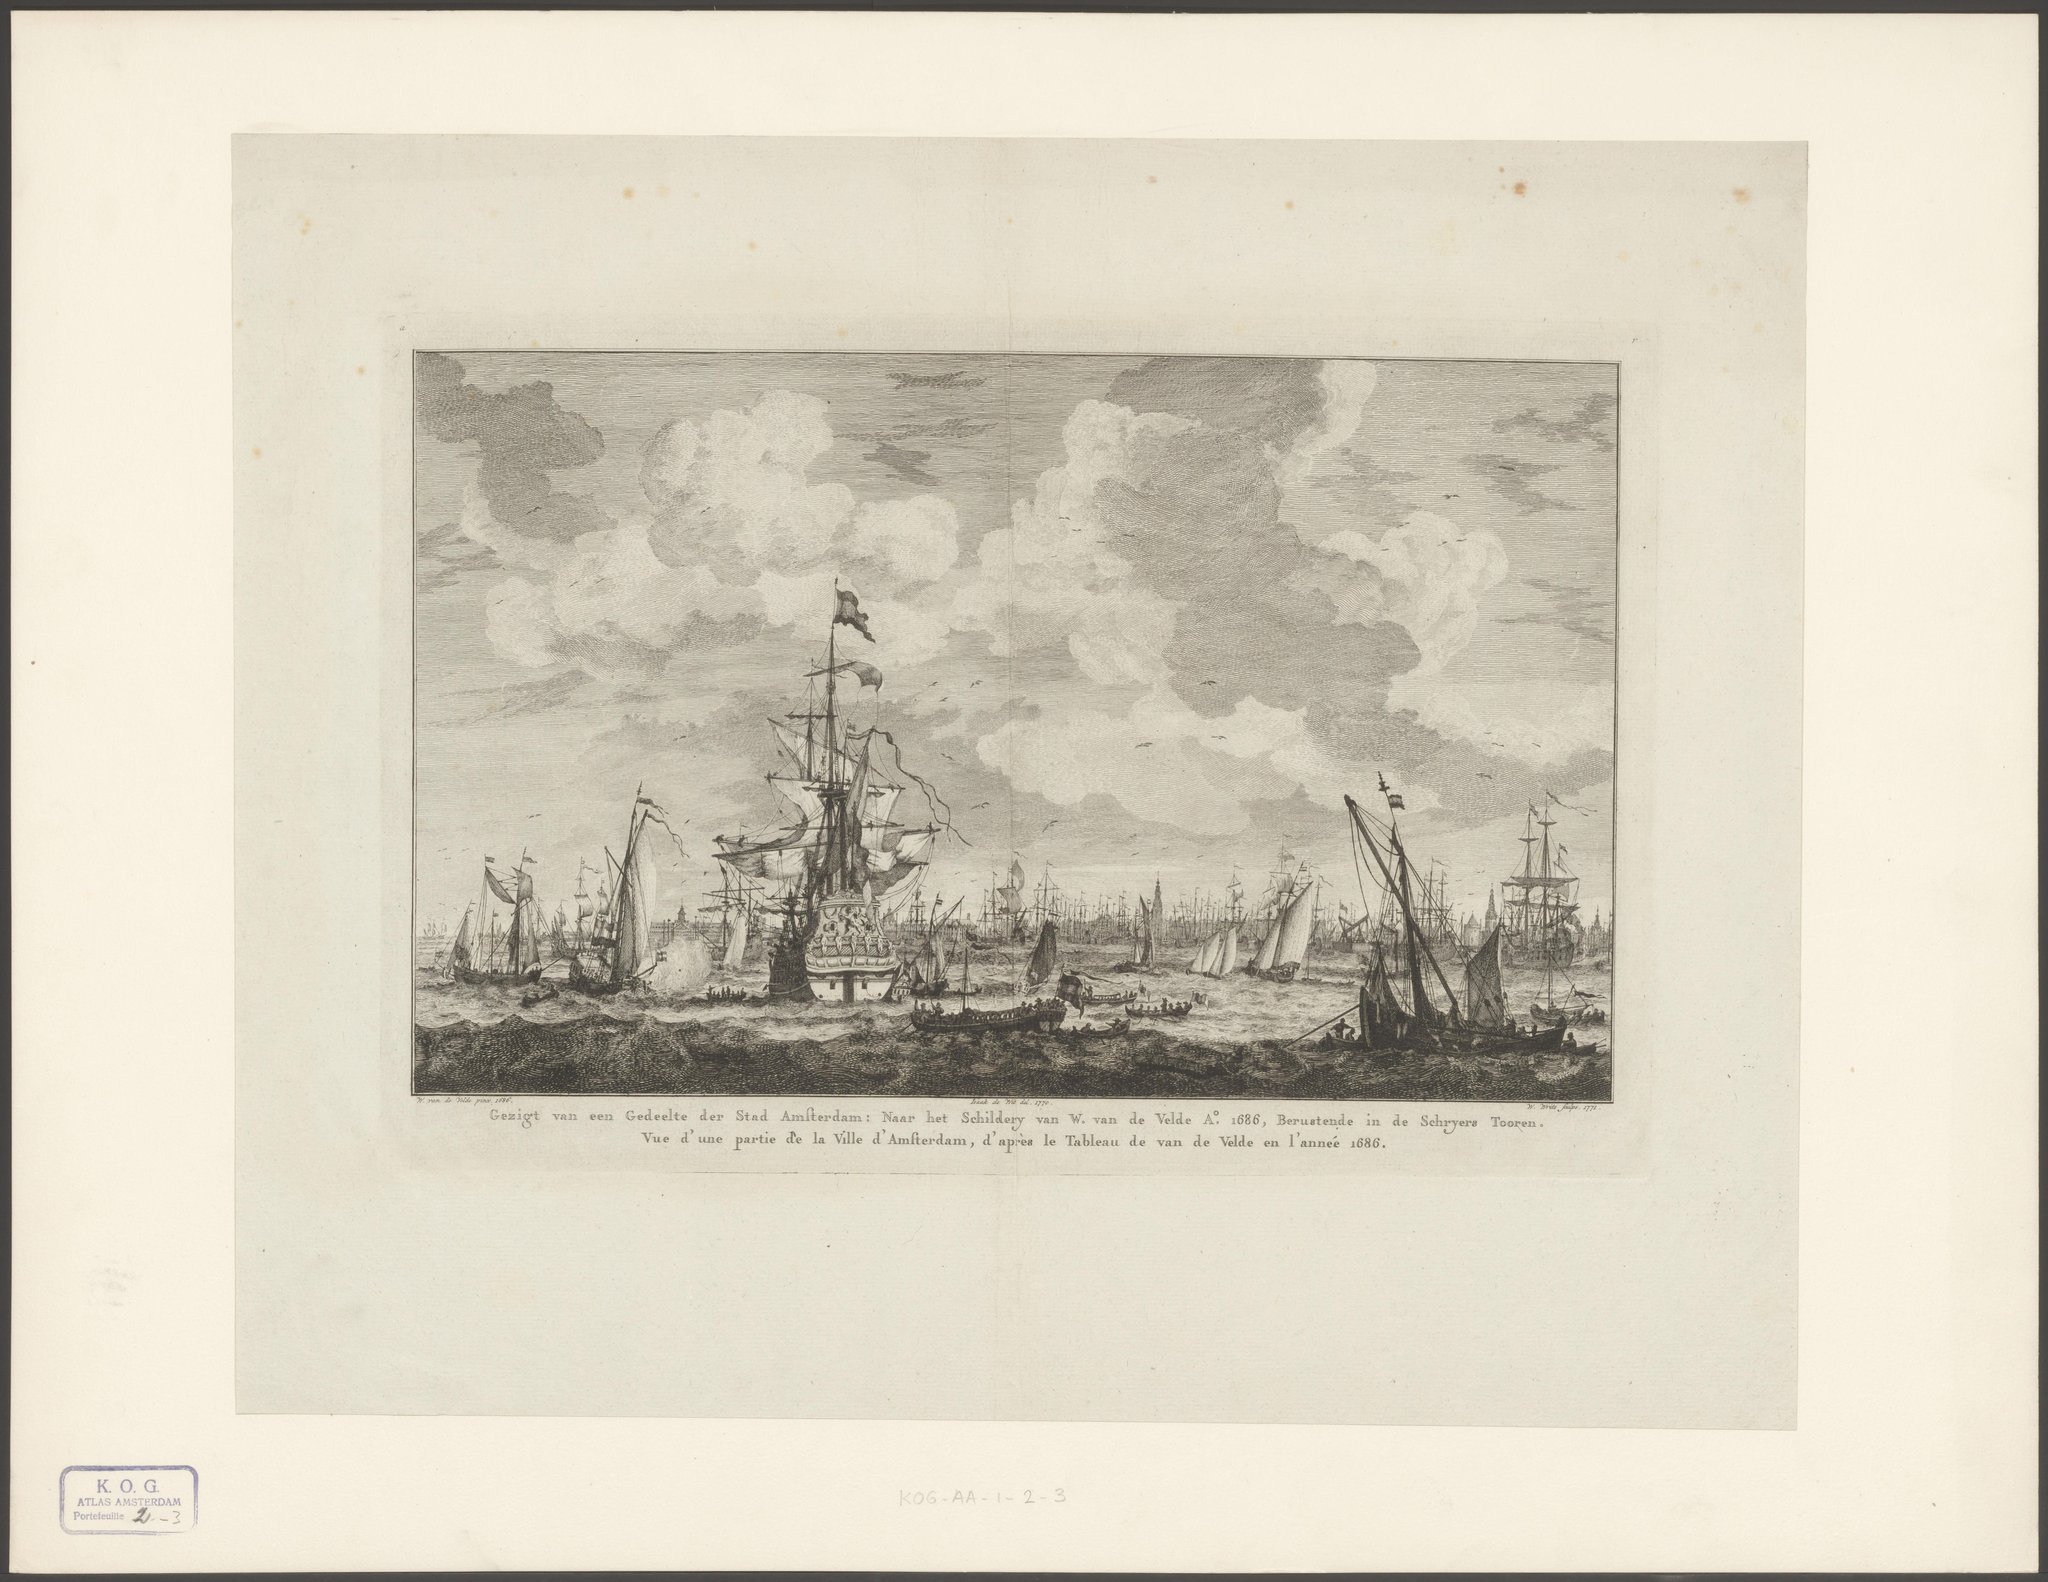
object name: print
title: Schepen op het IJ bij Amsterdam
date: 1771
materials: paper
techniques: etching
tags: city-view in general; 'veduta', river, ships (in general) - cc - more than one ship, amsterdam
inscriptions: collector's mark: ‘2-3’ Lugt 1641b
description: Onderwerpsrubriek binnen de Atlas Amsterdam: Gezichten van het IJ op het westelijk gedeelte der stad, Blauwhoofd tot Nieuwebrug.